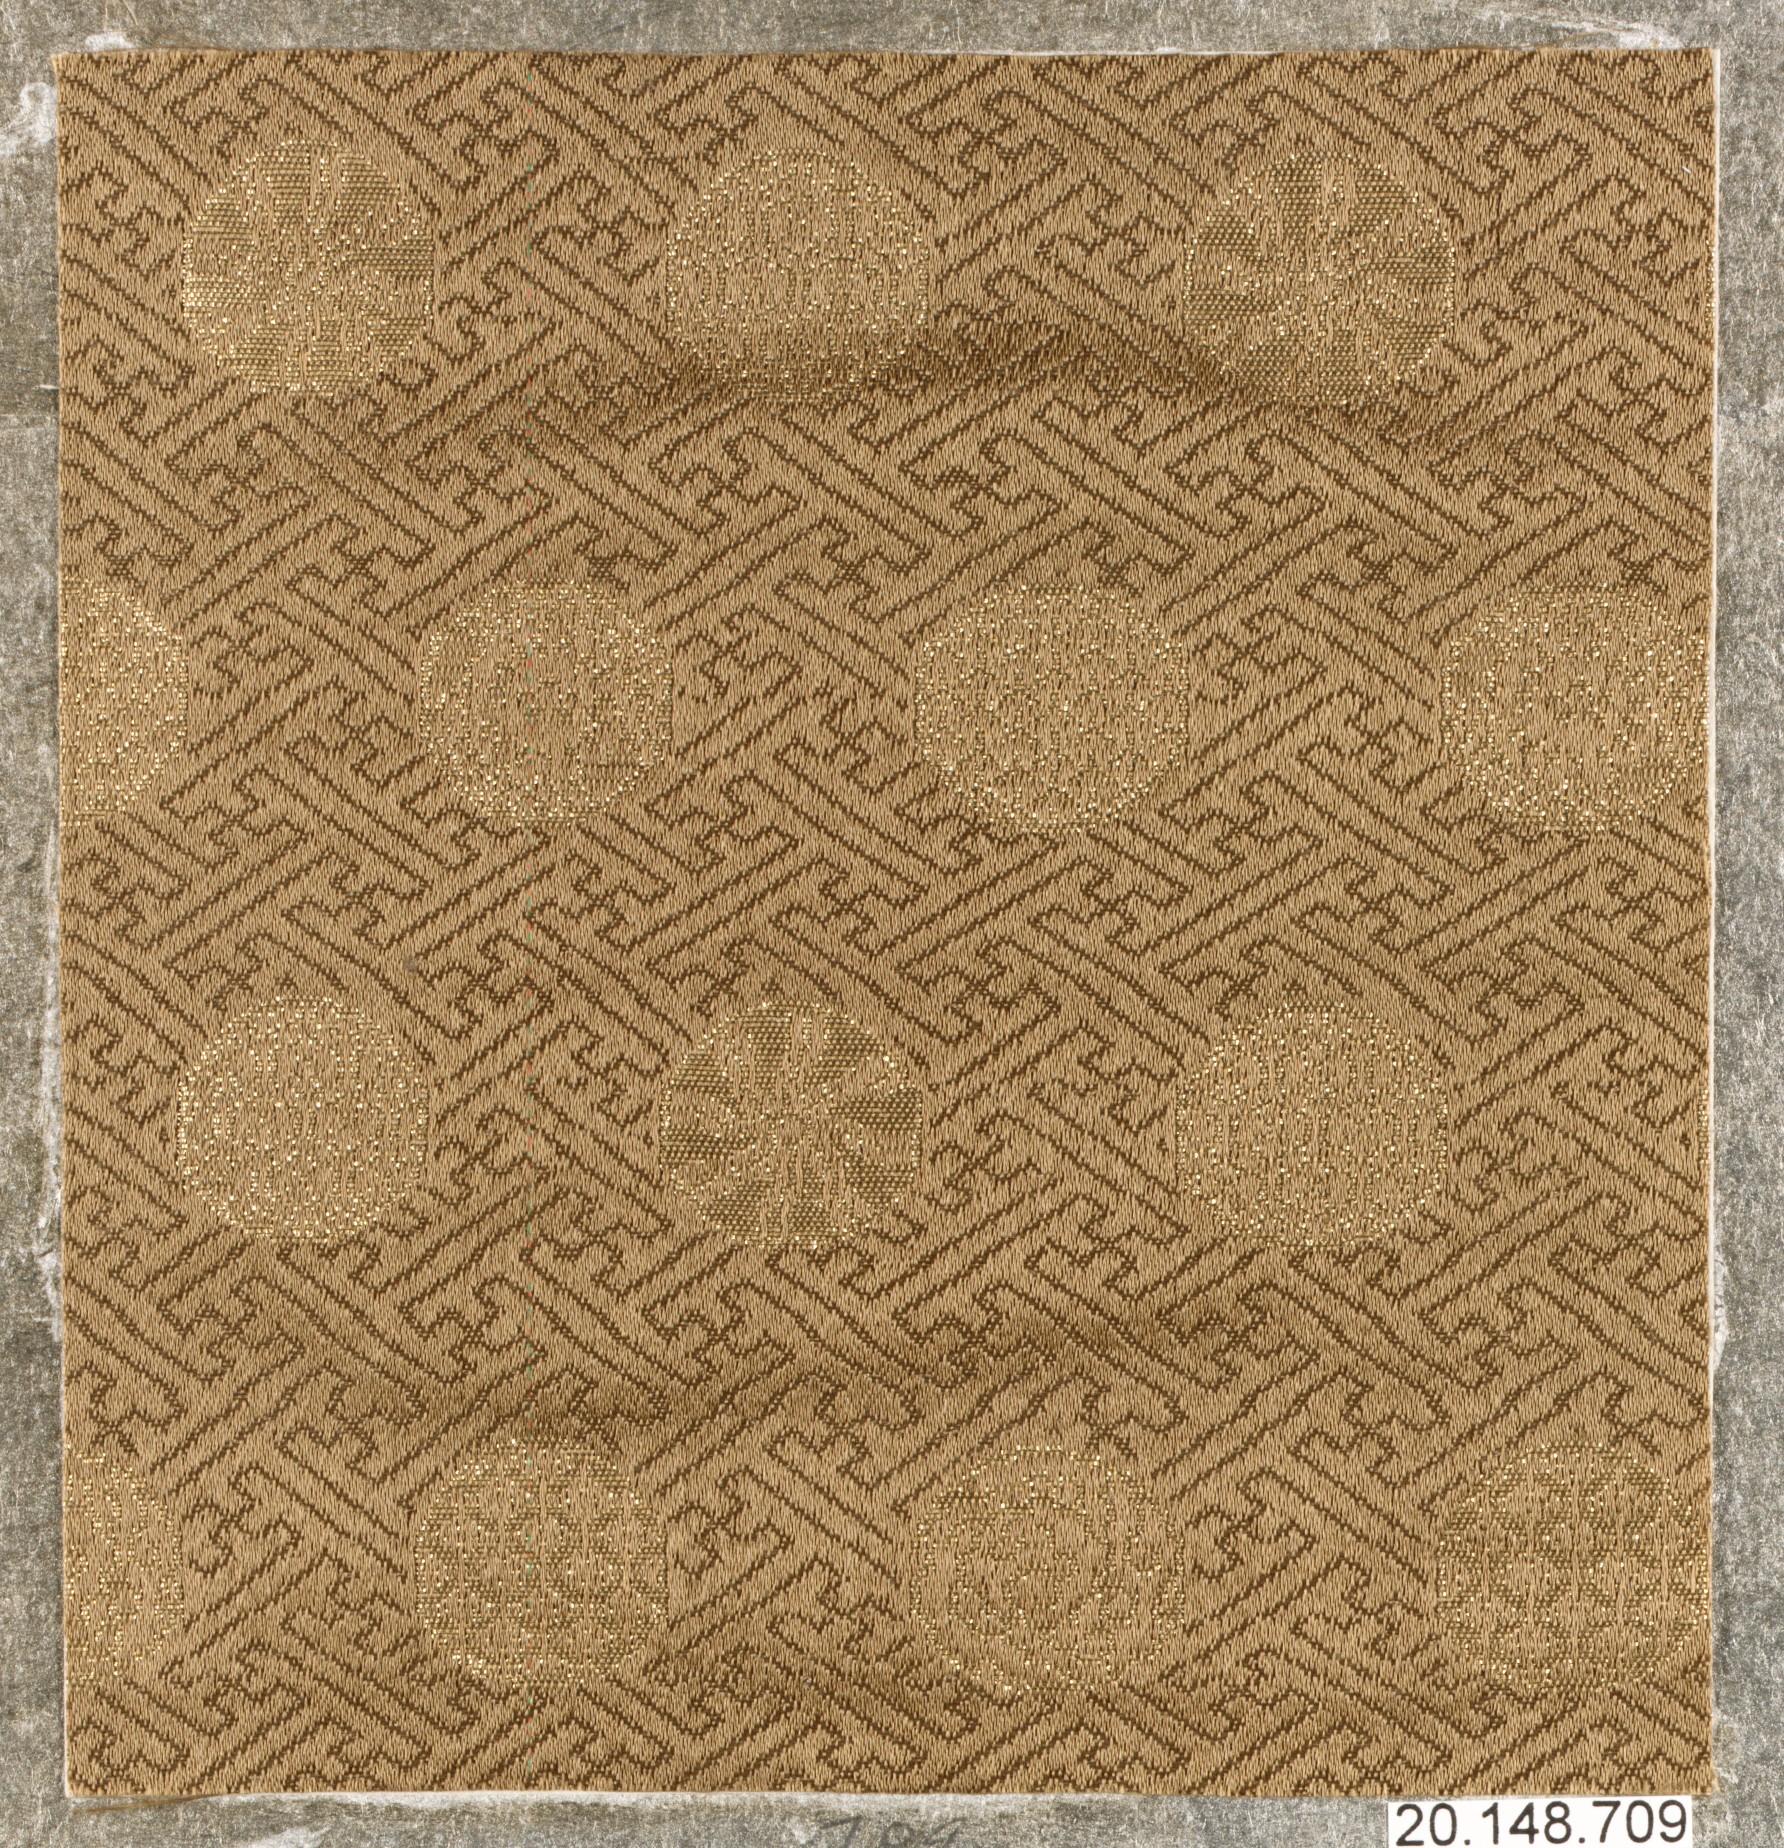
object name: piece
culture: japanese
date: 1701-1800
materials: silk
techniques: compound weave